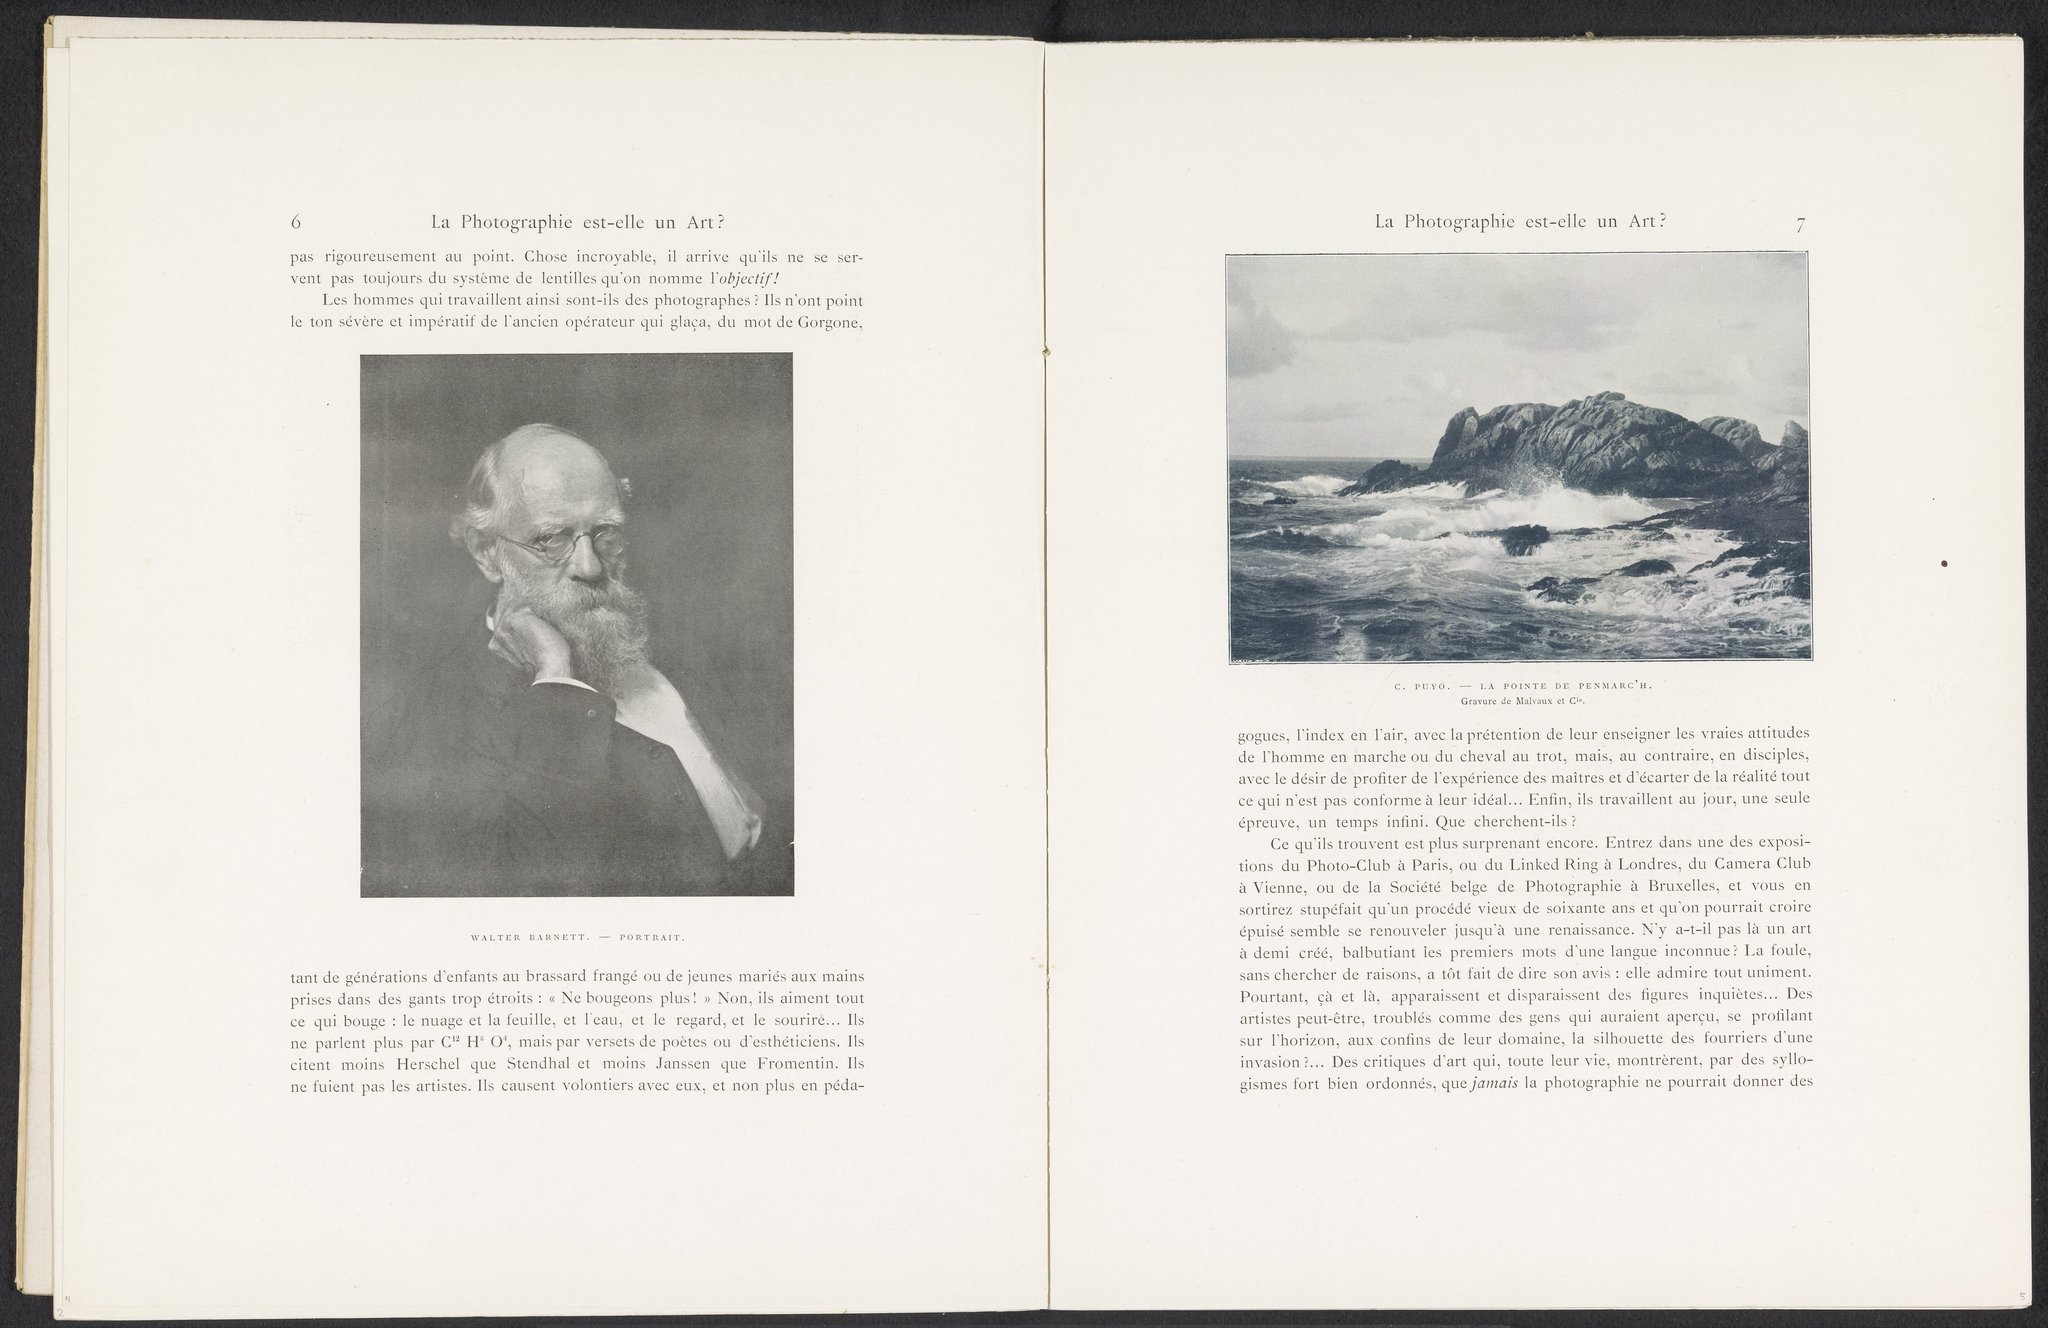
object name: photomechanical print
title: Portrait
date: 1889-1899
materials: paper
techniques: autotype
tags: adult man